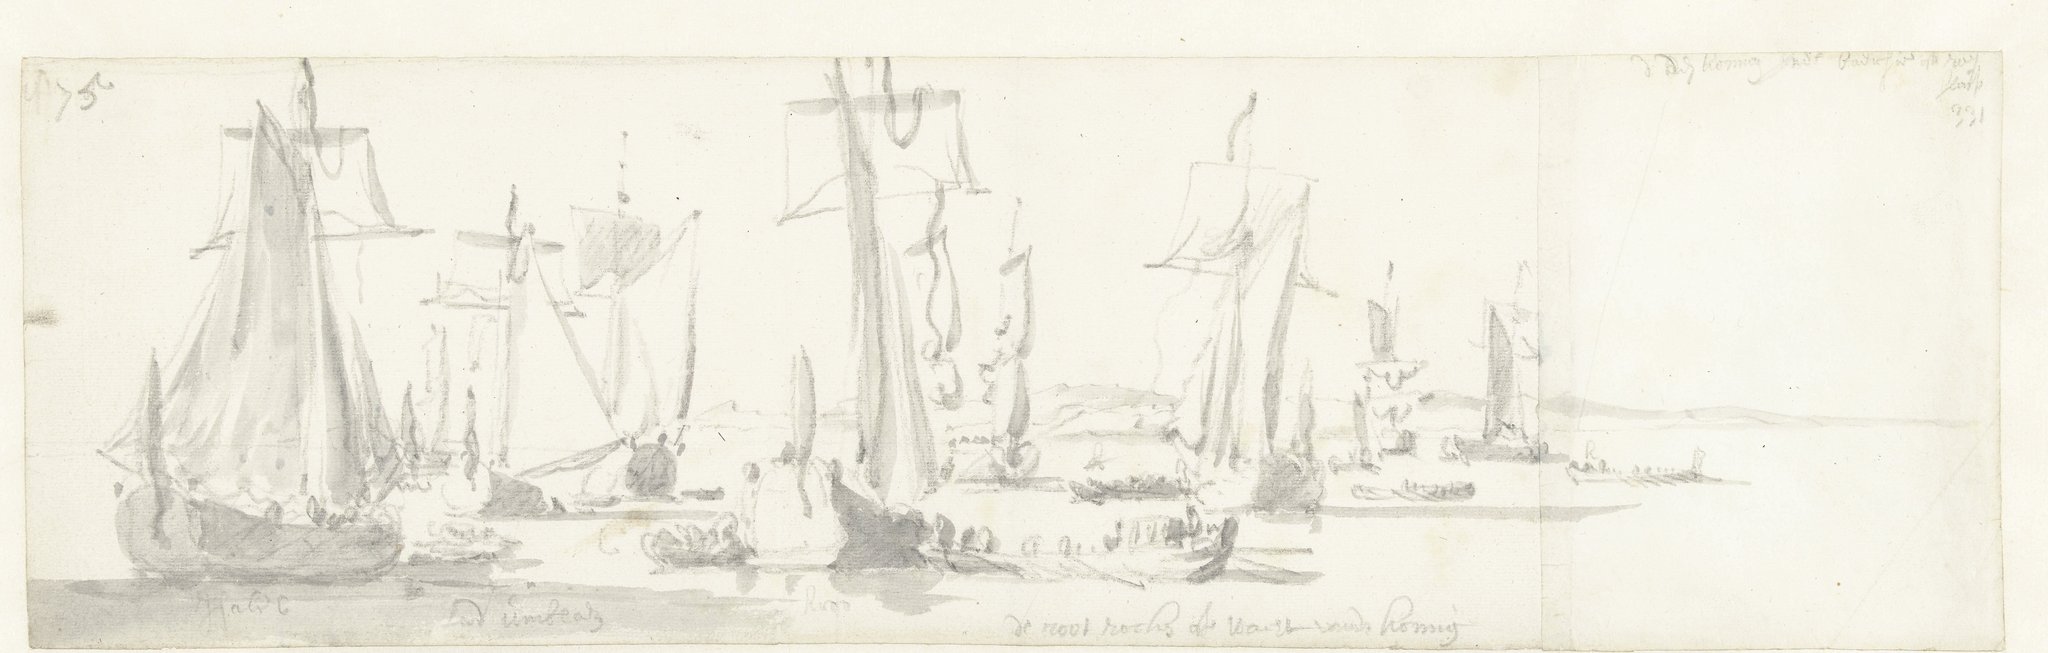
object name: drawing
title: De tocht van de Engelse koning Karel II over de Thames naar Sheerness en Chatham op 27 Augustus 1681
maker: willem van de velde (i)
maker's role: draughtsman, painter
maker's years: 1611-1693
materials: chalk, paper, pencil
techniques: brush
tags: karel ii (koning van engeland), sailing-ship, sailing-boat, names of artefacts and man-made objects (buildings excluded), river, sailing-ship, sailing-boat (eastindiaman), visiting; receiving guests; elegant company, sailing-ship, sailing-boat (with name), thames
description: De tocht van de Engelse koning Karel II over de Thames naar Sheerness en Chatham op 27 Augustus 1681. Hier bezoekt de koning twee Oostindiëvaarders te Erith, links enkele jachten.